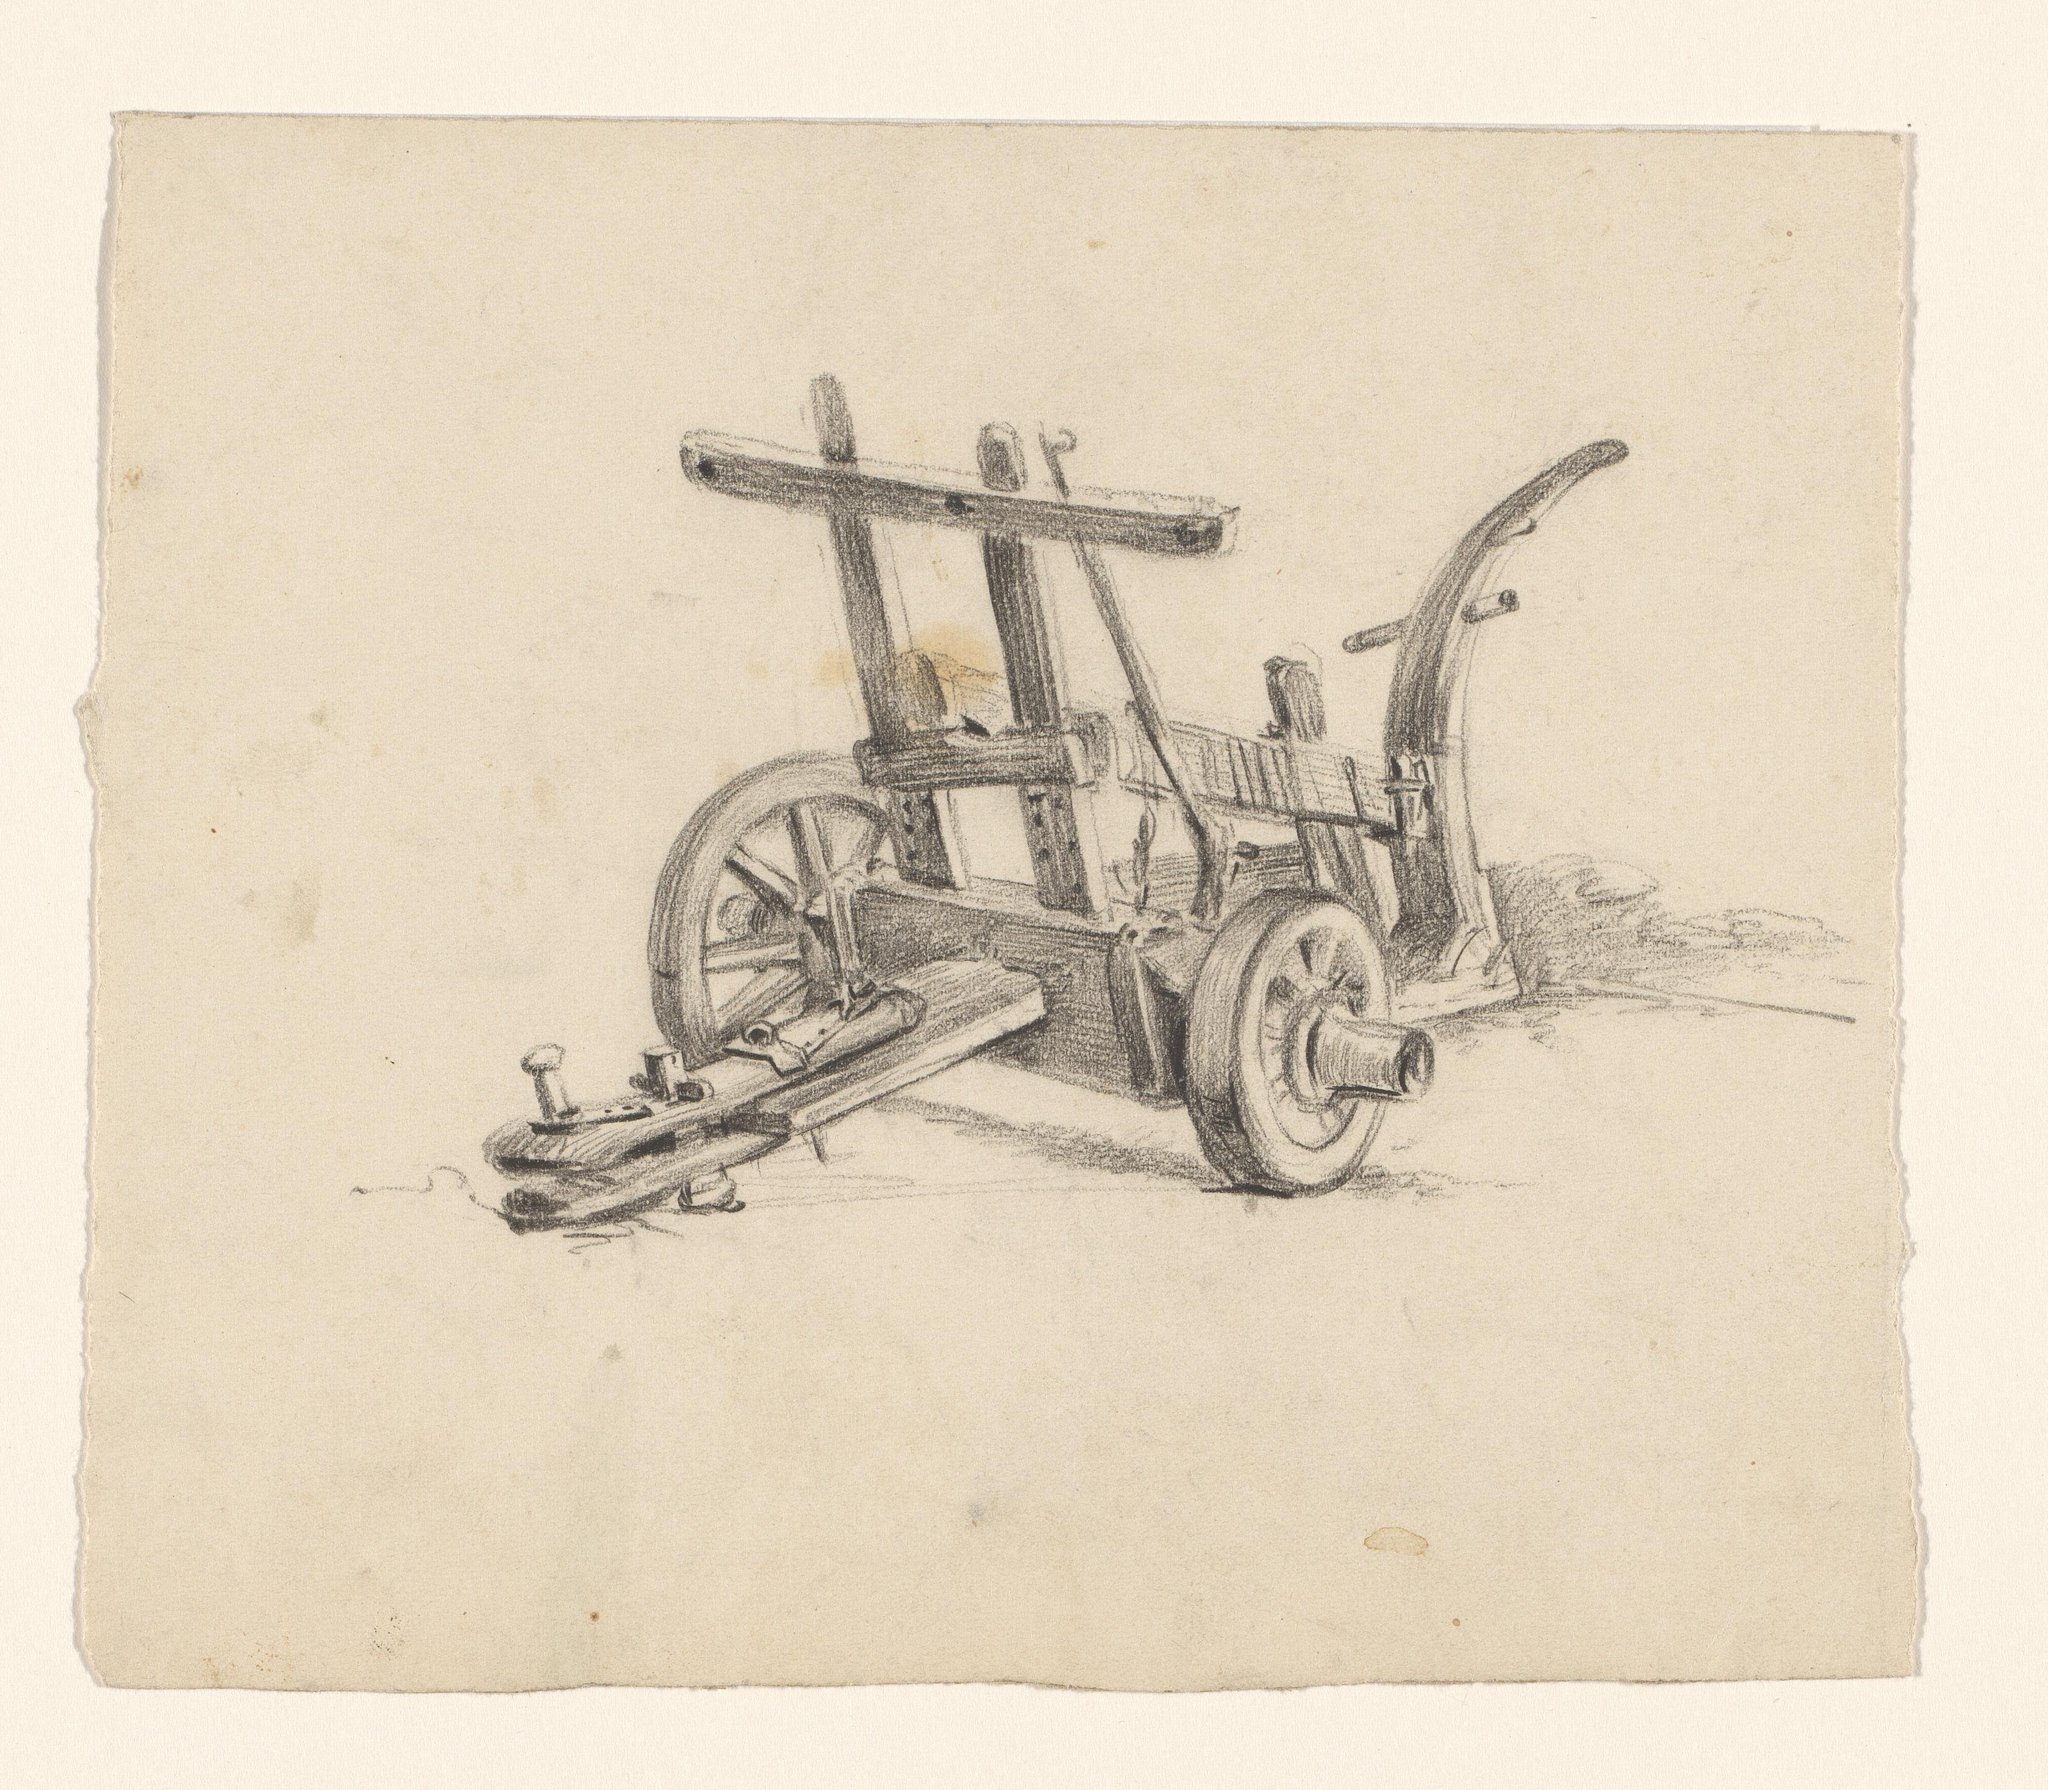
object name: drawing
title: Paardenploeg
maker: jan bedijs tom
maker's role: draughtsman, painter, print maker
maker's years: 1813-1894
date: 1823-1894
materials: chalk, paper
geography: the hague